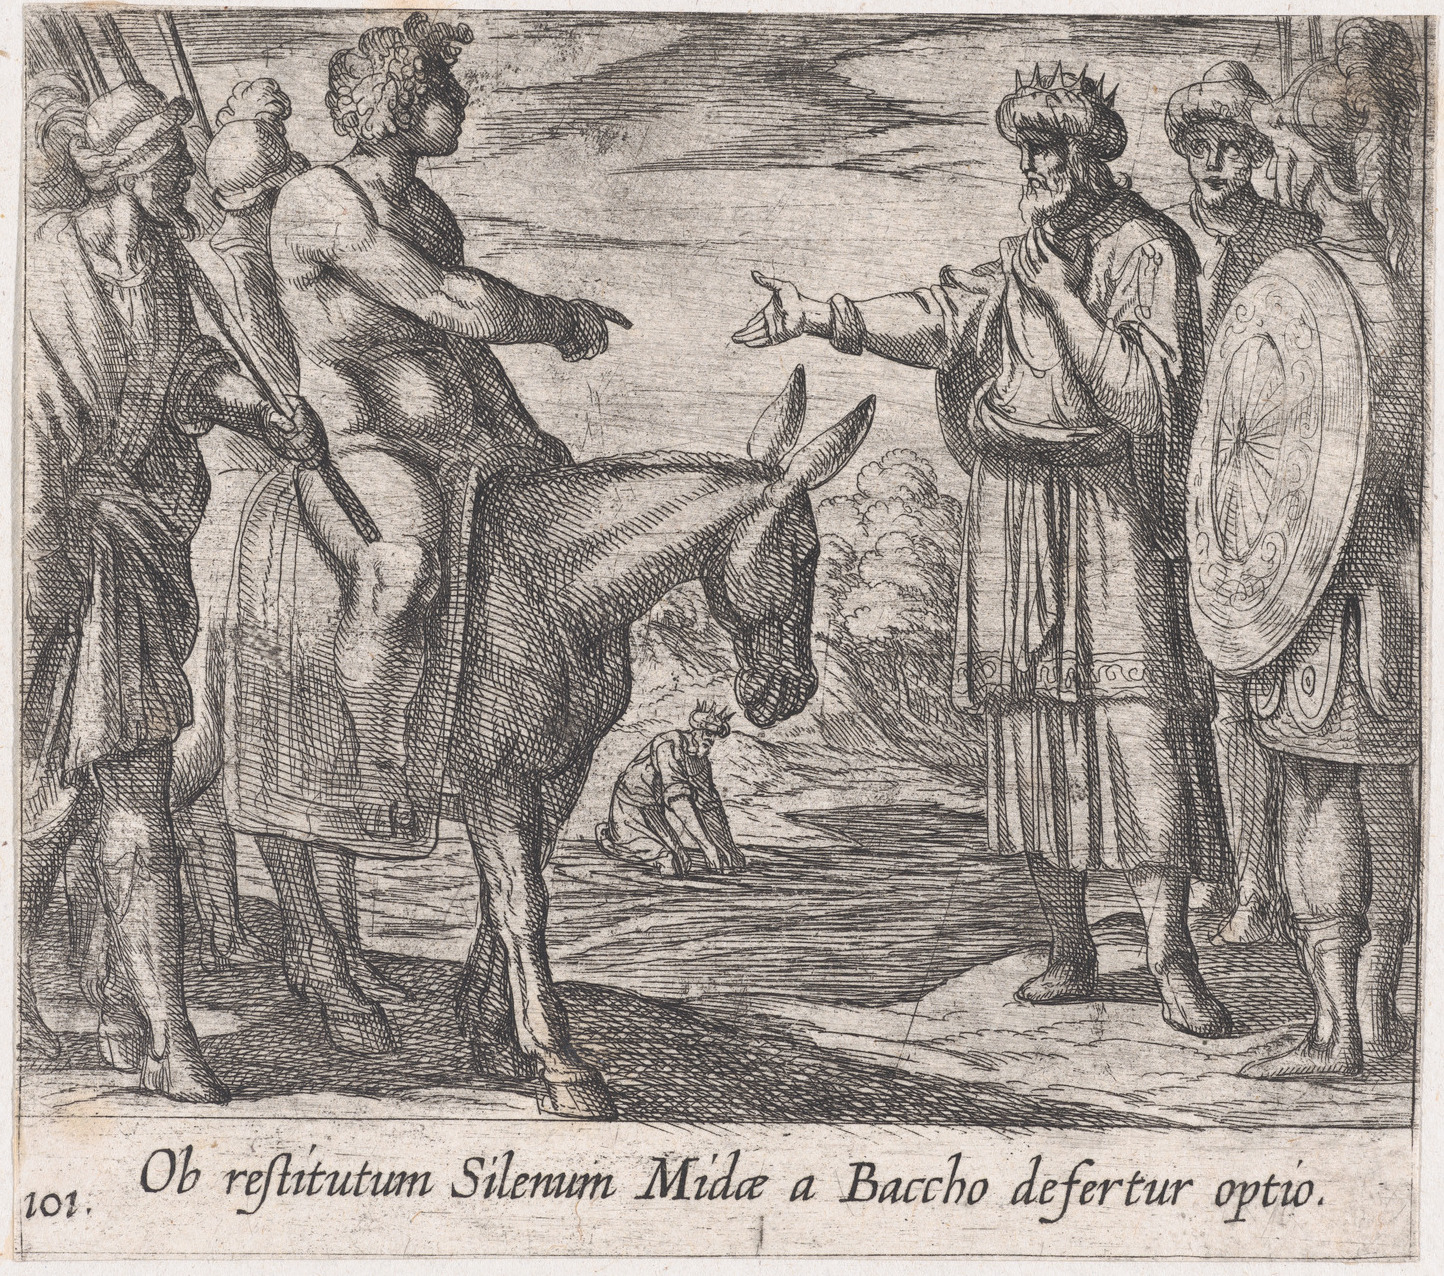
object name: print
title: Plate 101: Bacchus Granting Midas's Wish (Ob restitutum Silenum Midae a Baccho Defertur optio), from Ovid's 'Metamorphoses'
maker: antonio tempesta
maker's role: artist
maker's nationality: italian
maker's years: 1555-1630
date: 1606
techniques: etching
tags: soldiers,kings,midas,bacchus,horses